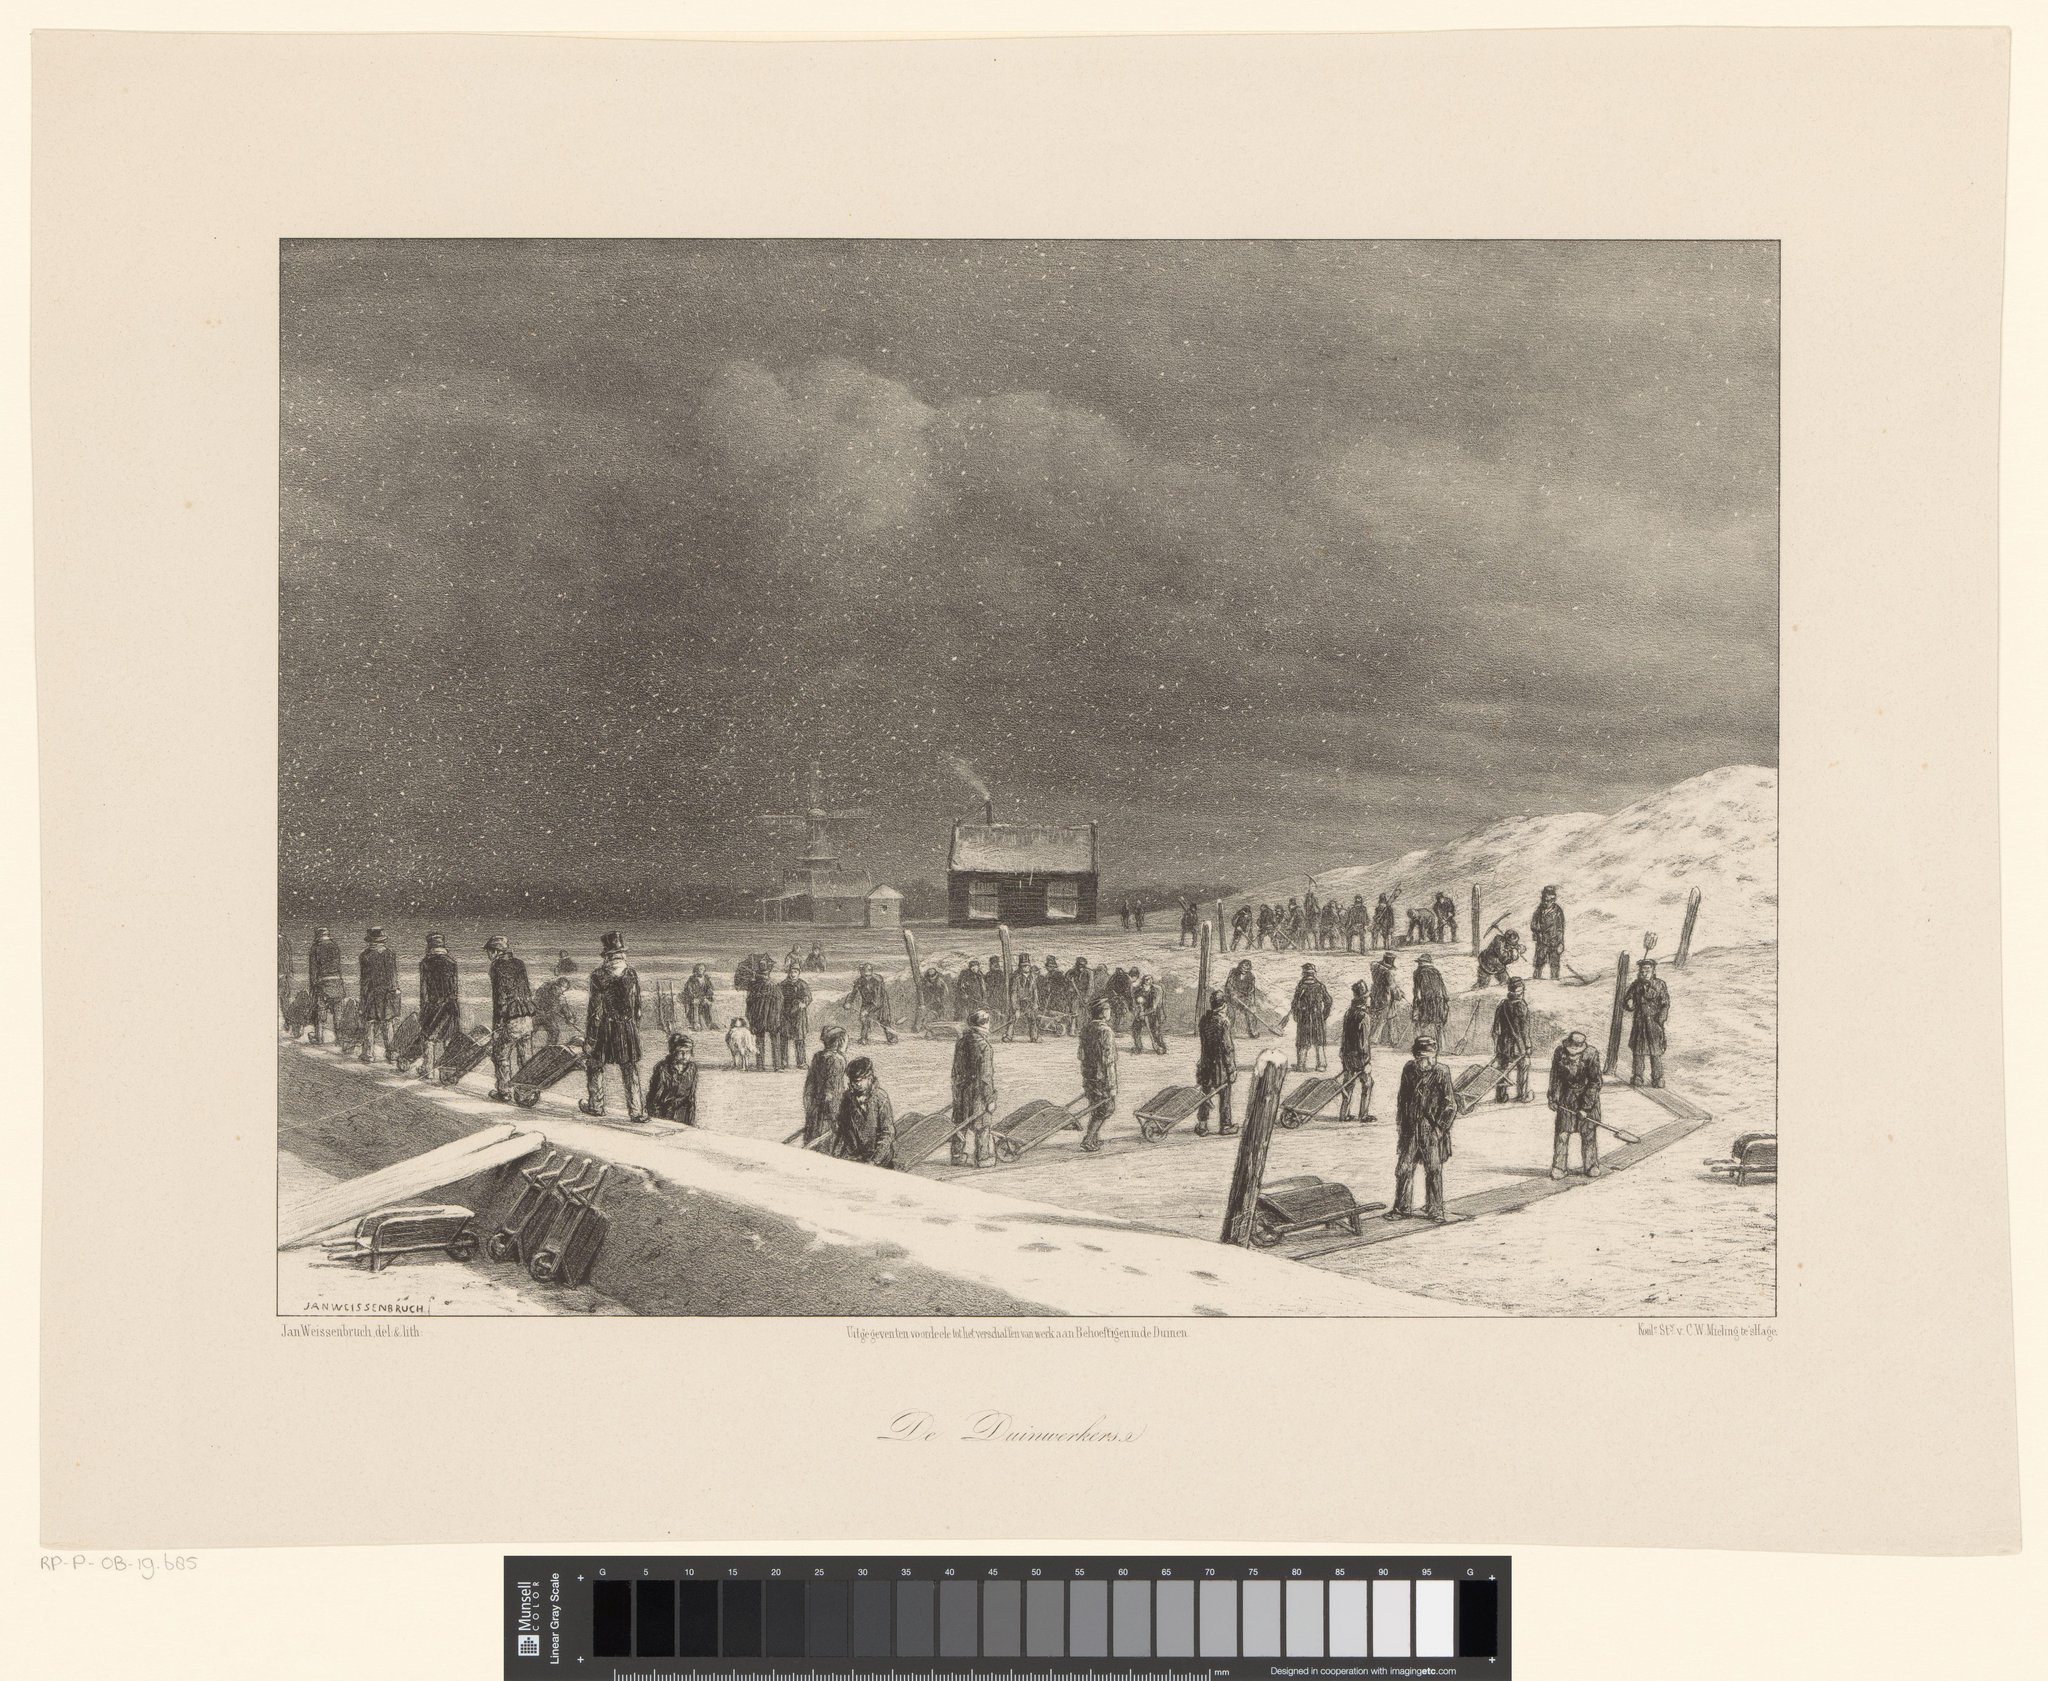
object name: print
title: De Duinwerkers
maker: jan weissenbruch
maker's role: painter, print maker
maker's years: 1822-1880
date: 1865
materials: paper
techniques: lithograph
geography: the hague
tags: digging (industrial process) (+ men (labourers)), dunes (sea not visible); in the dunes, working class, labourers, snow, the hague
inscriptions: collector's mark: Lugt 2228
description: Zandafgraving in de duinen bij Den Haag, winter 1846. Arbeiders zijn bezig met het afgraven van duinen ten behoeve van de bouw van een Koninklijke Stoeterij. In ploegen wordt het zand met kruiwagens verplaatst onder donkere lucht waaruit een sneeuwbui valt. In de verte een gebouw en een windmolen.